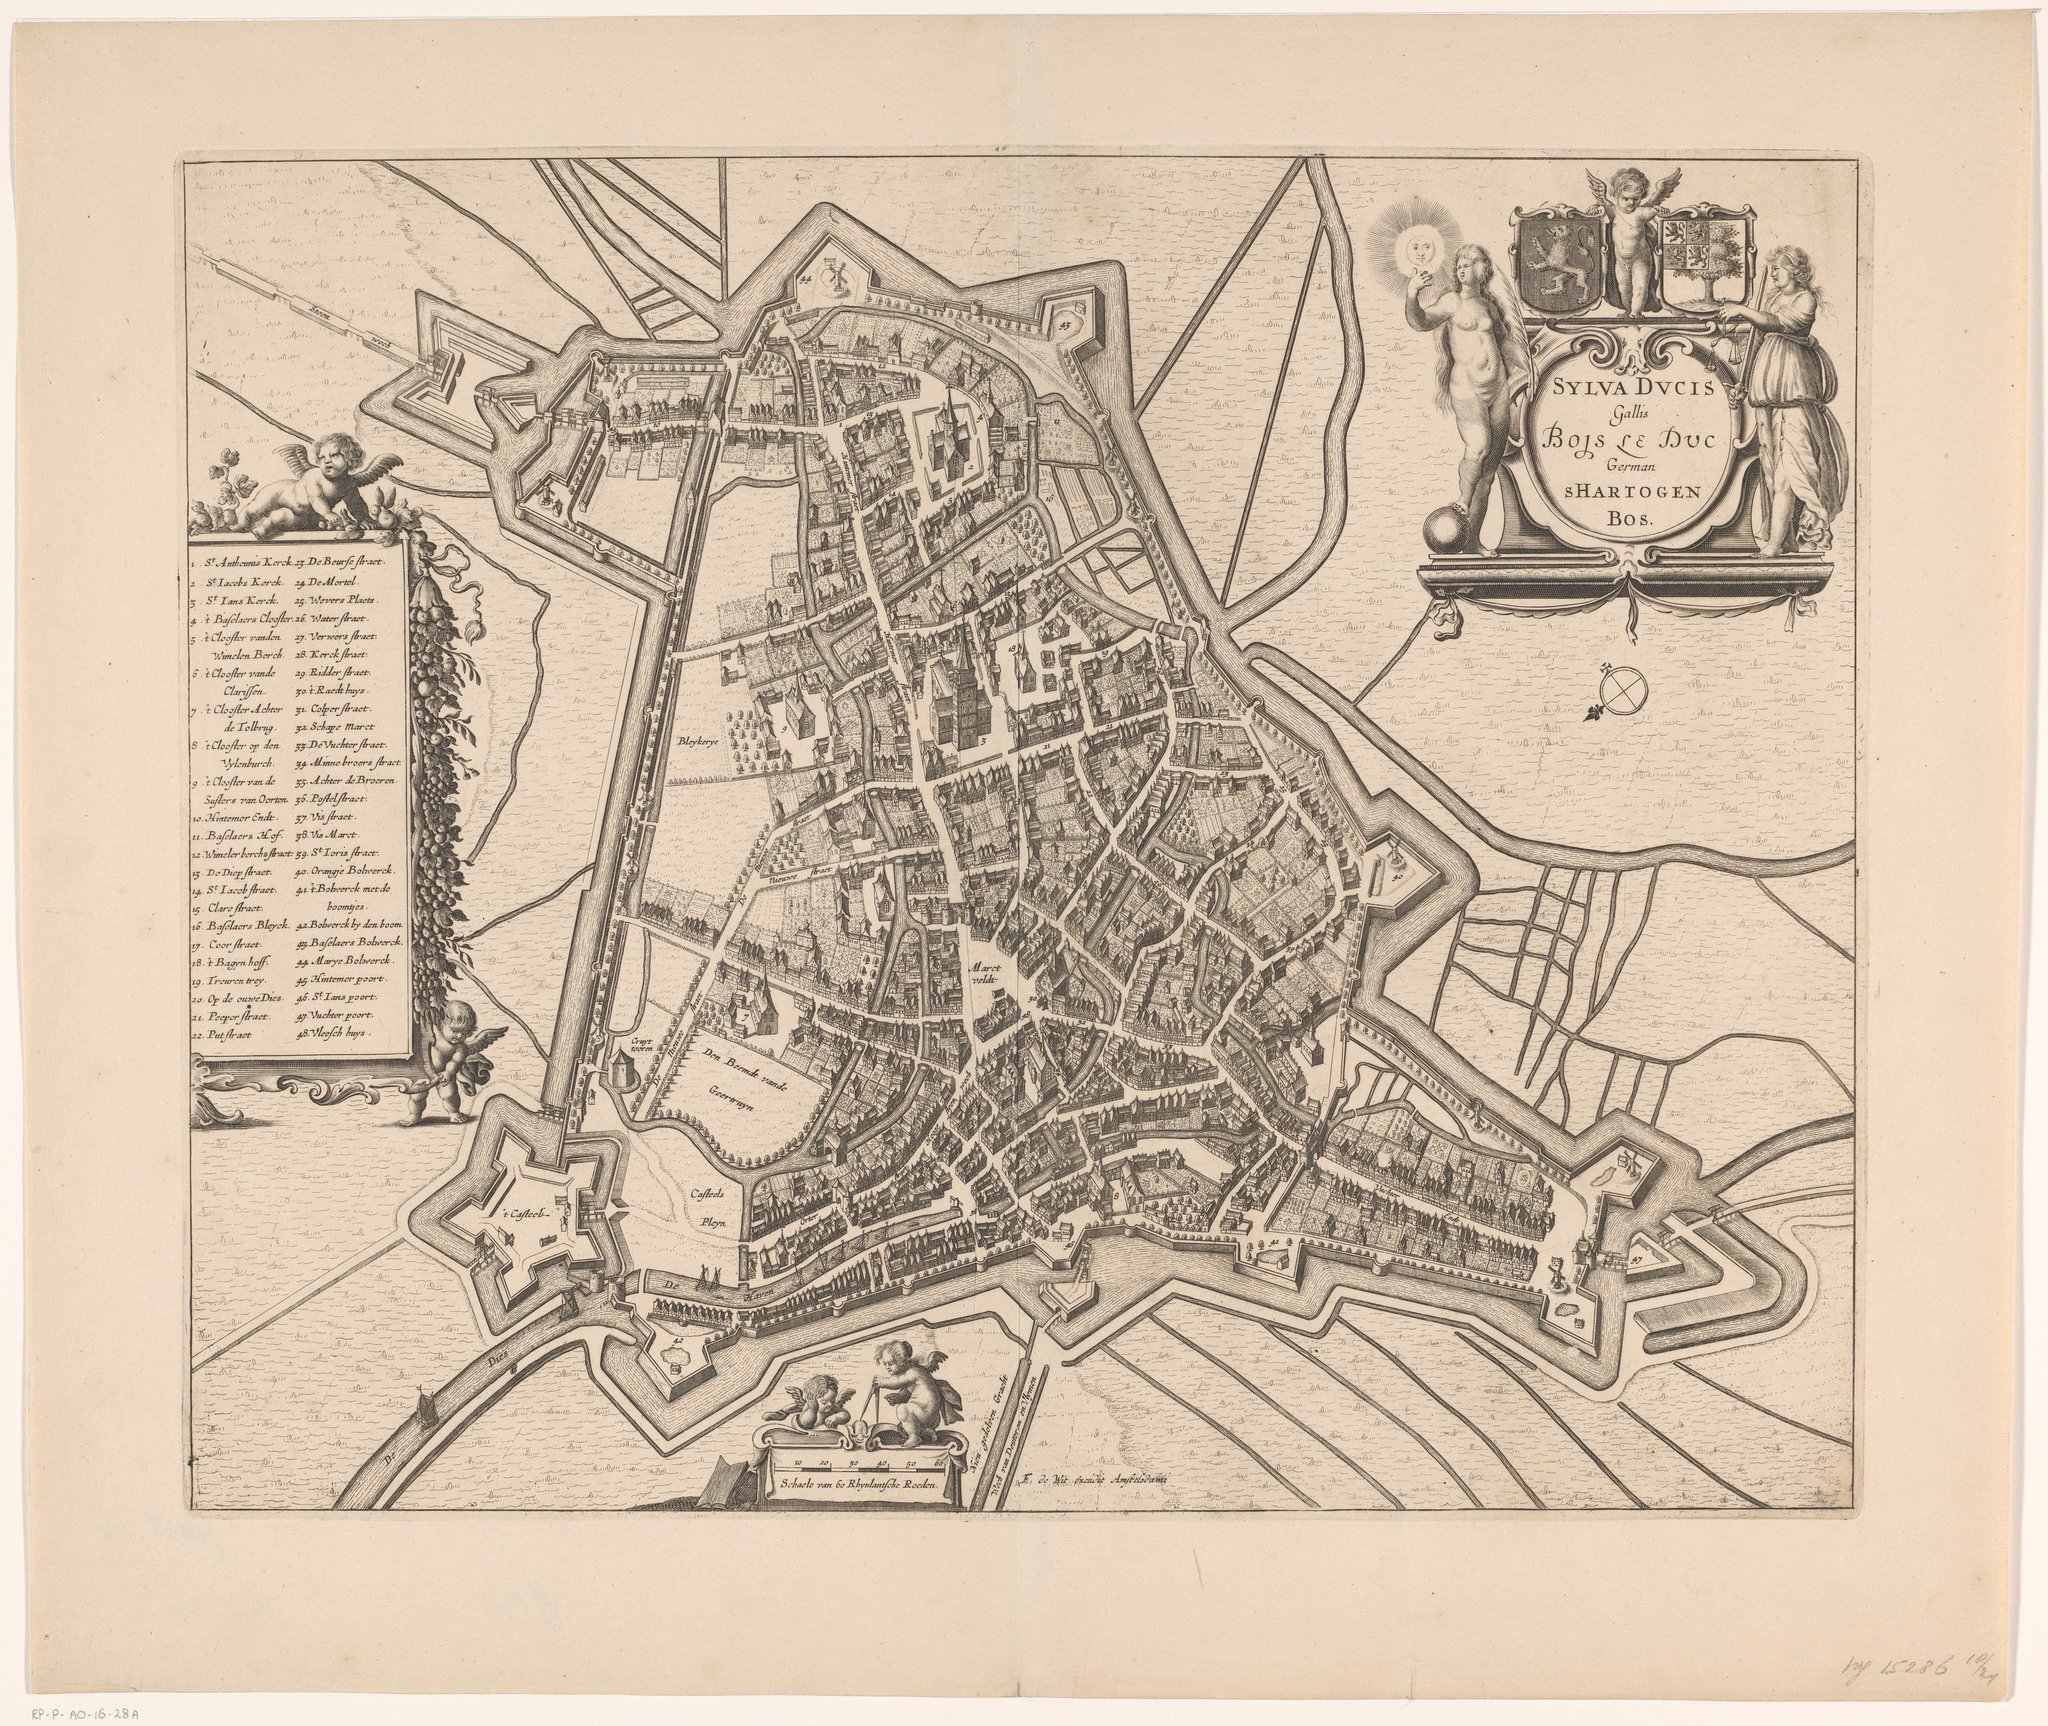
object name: area plan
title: Plattegrond van 's-Hertogenbosch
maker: Anonymous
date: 1657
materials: paper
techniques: engraving, etching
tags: coat of arms (as symbol of the state, etc.) (+ city; municipal), justitia (justice) as roman personification, maps of cities, coat of arms (as symbol of the state, etc.) (+ province; provincial), den bosch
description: Prent ook gebruikt in: Theatrum ichnographicum omnium urbium et praecipuorum oppidorum Belgicarum XVII Provinciarum (…). Amsterdam: Frederik de Wit, ca. 1698-1704. En in: Theatrum ichnographicum omnium urbium et praecipuorum oppidorum Belgicarum XVII Provinciarum (…). Amsterdam: Frederik de Wit, ca. 1700-1710. En in: Aa, Pieter van der. La galerie agreable du monde (…). 66 delen. Leiden: Pieter van der Aa, 1728, dl. 16.